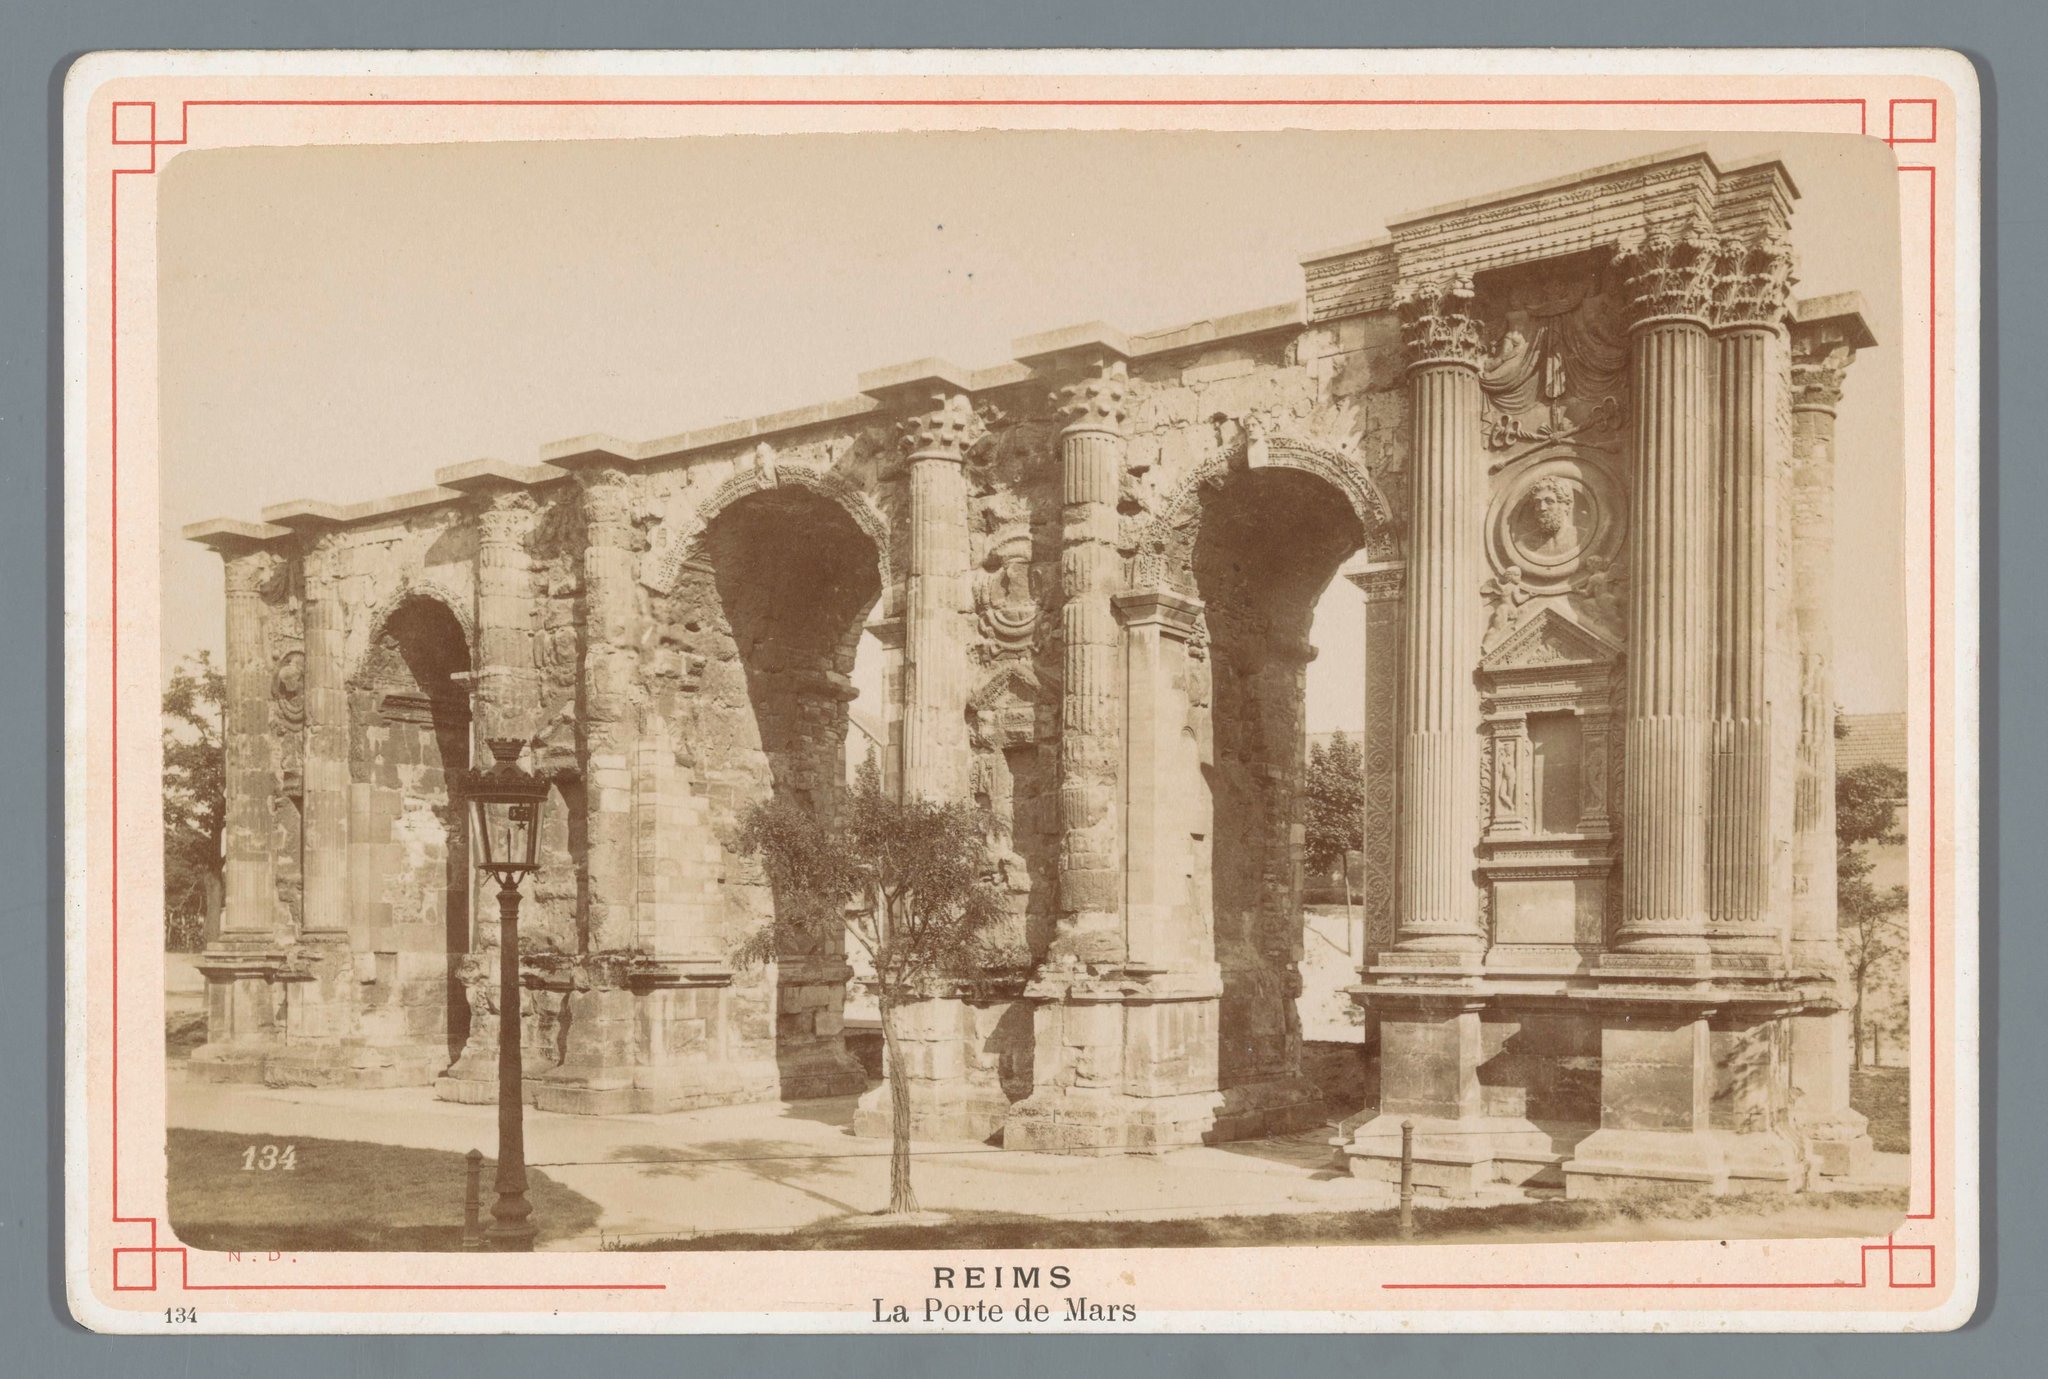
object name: cabinet photograph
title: La Porte de Mars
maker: étienne neurdein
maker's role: publisher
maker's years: 1832-1918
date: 1870-1900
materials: cardboard, photographic support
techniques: albumen print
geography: reims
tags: parts of church exterior and annexes, façade (of house or building)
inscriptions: number: ‘134’, number: ‘134’, initials: ‘N.D.’